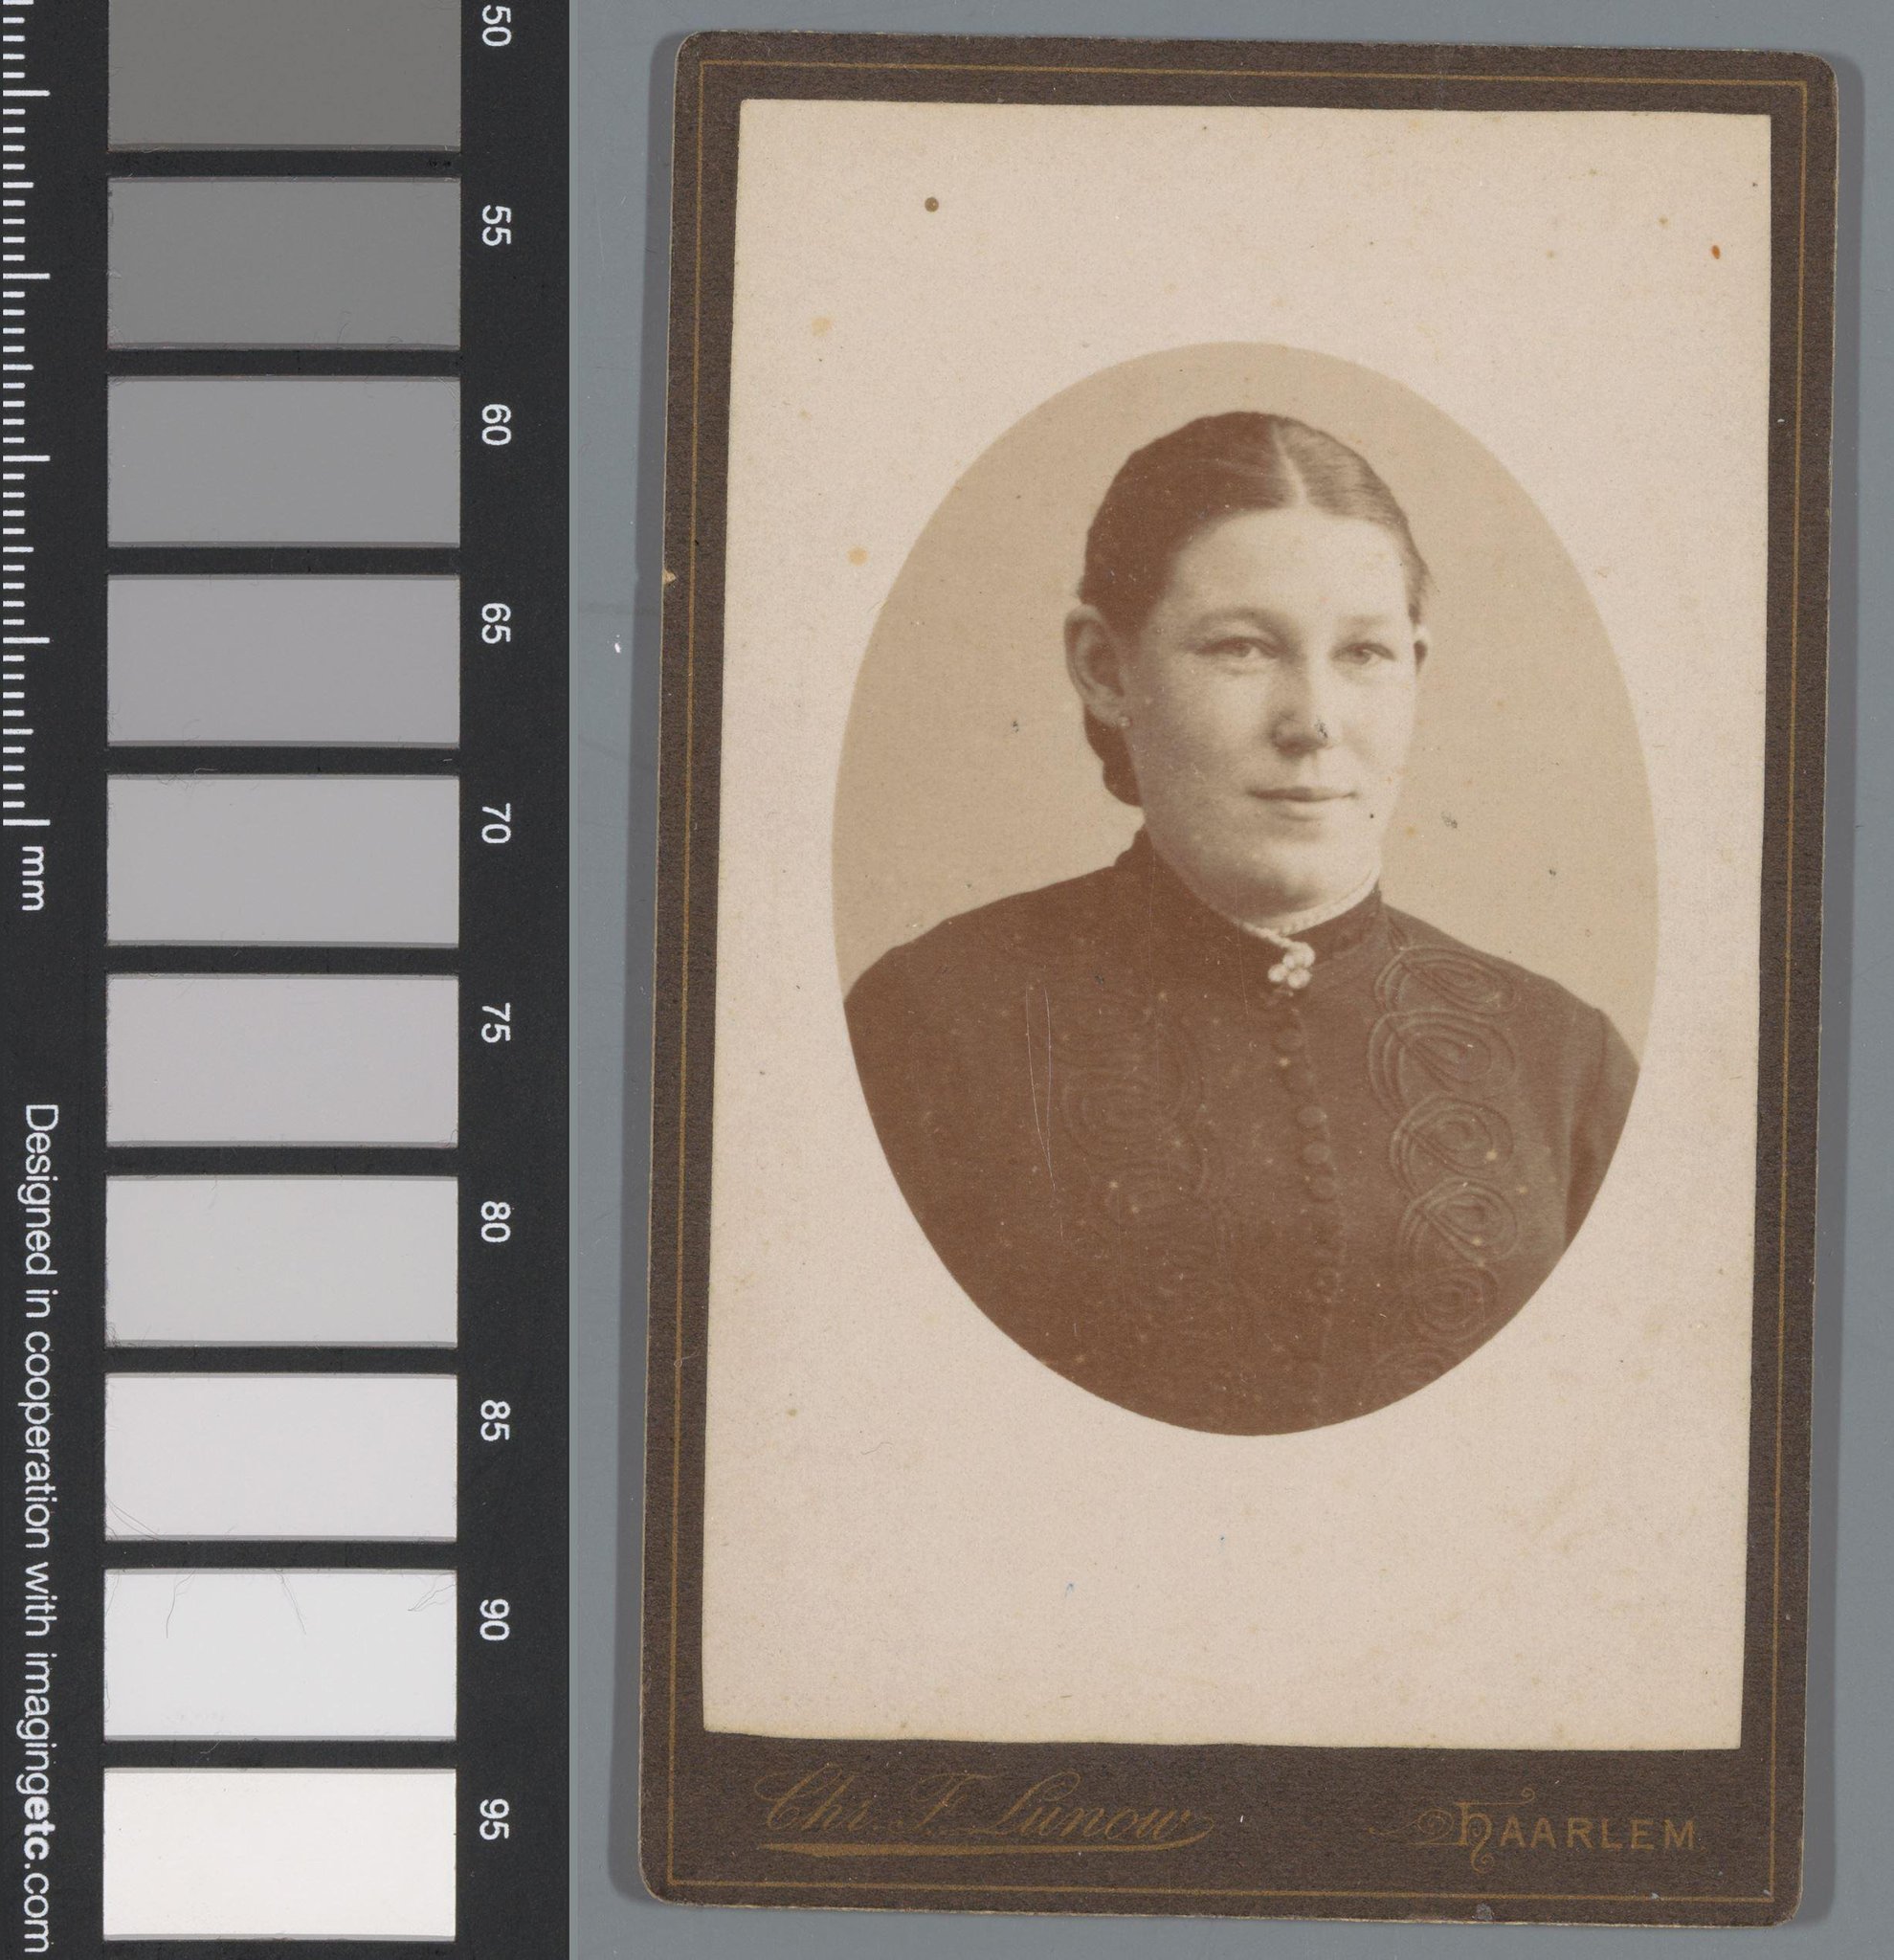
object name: photograph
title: Portret van een onbekende vrouw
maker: fredrich christiaan lünow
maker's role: fotograaf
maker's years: 1857-1925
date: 1888-1899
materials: cardboard, paper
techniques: albumen print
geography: haarlem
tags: historical persons - bb - woman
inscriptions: inscription: ‘Chr. F. Lunow/ PHOTOGRAAF/ HAARLEM/ Barteljoresstraat 17./ ALEX LINDNER. BERLIN.’